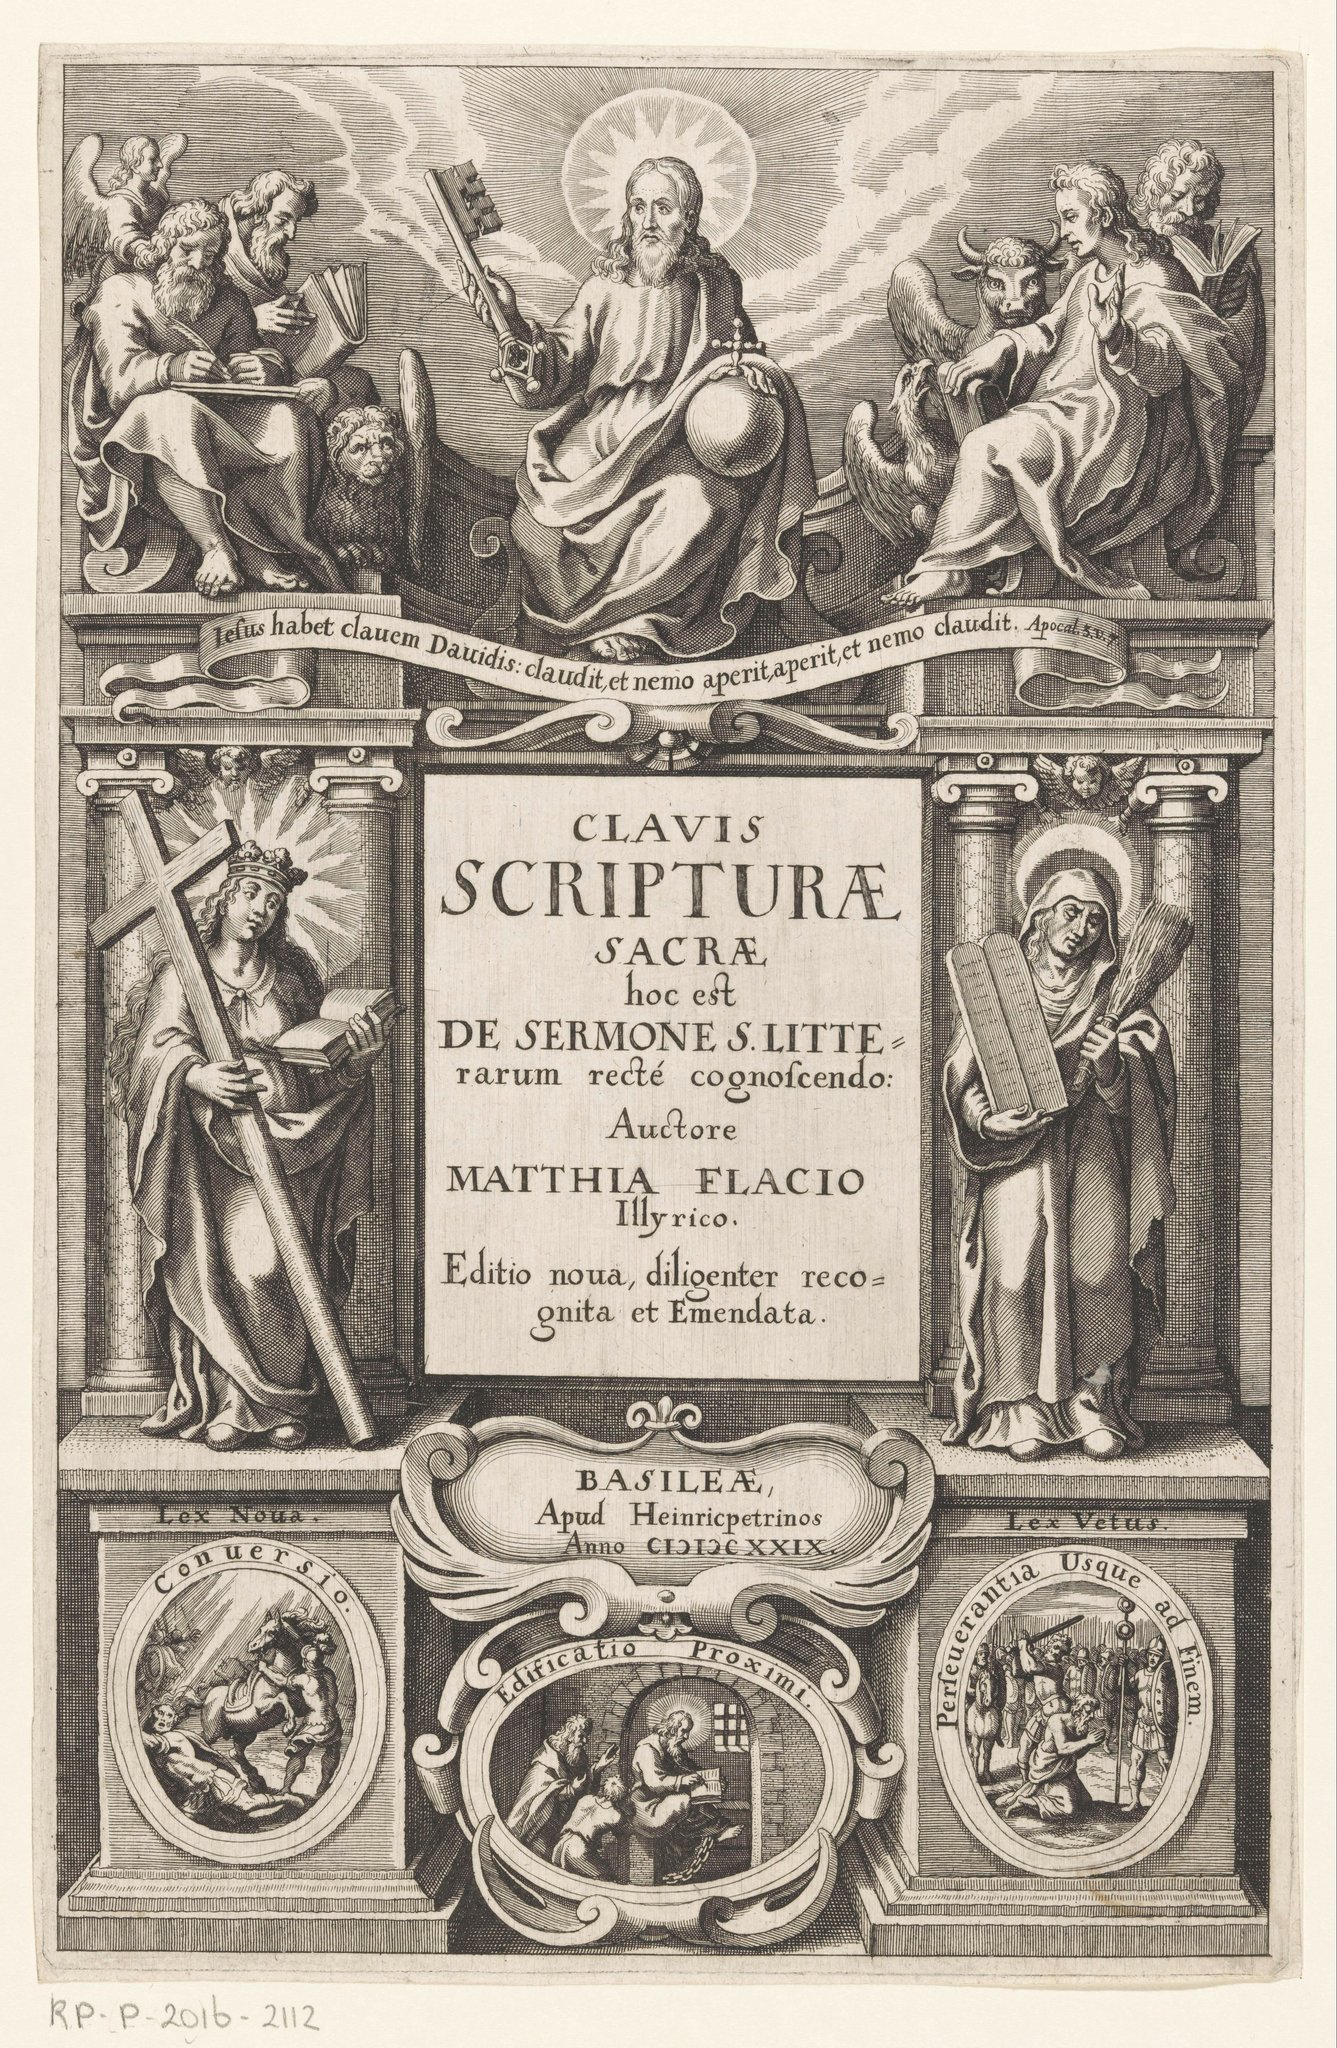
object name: titelblad, titelpagina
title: Clavis scripturae sacrae hoc est de sermone s. litterarum recté cognoscendo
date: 1629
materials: paper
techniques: engraving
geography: basel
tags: evangelists, usually with books or scrolls (not in biblical context), old testament and new testament ~ christian doctrine, christ, the apostle paul of tarsus; possible attributes: book, scroll, sword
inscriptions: collector's mark: Lugt 240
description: Christus met rijksappel en sleutel zit te midden van de vier evangelisten met bijbehorende wezens. Onder hen de boektitel geflankeerd door de personificaties van het Nieuwe Geloof (Lex Nova) met kruis en boek en het Oude Geloof (Lex Vetus) met roe en stenen tafelen. Aan de onderzijde drie cartouches met scènes uit het leven van Paulus: zijn bekering, zijn gevangenschap en zijn dood.